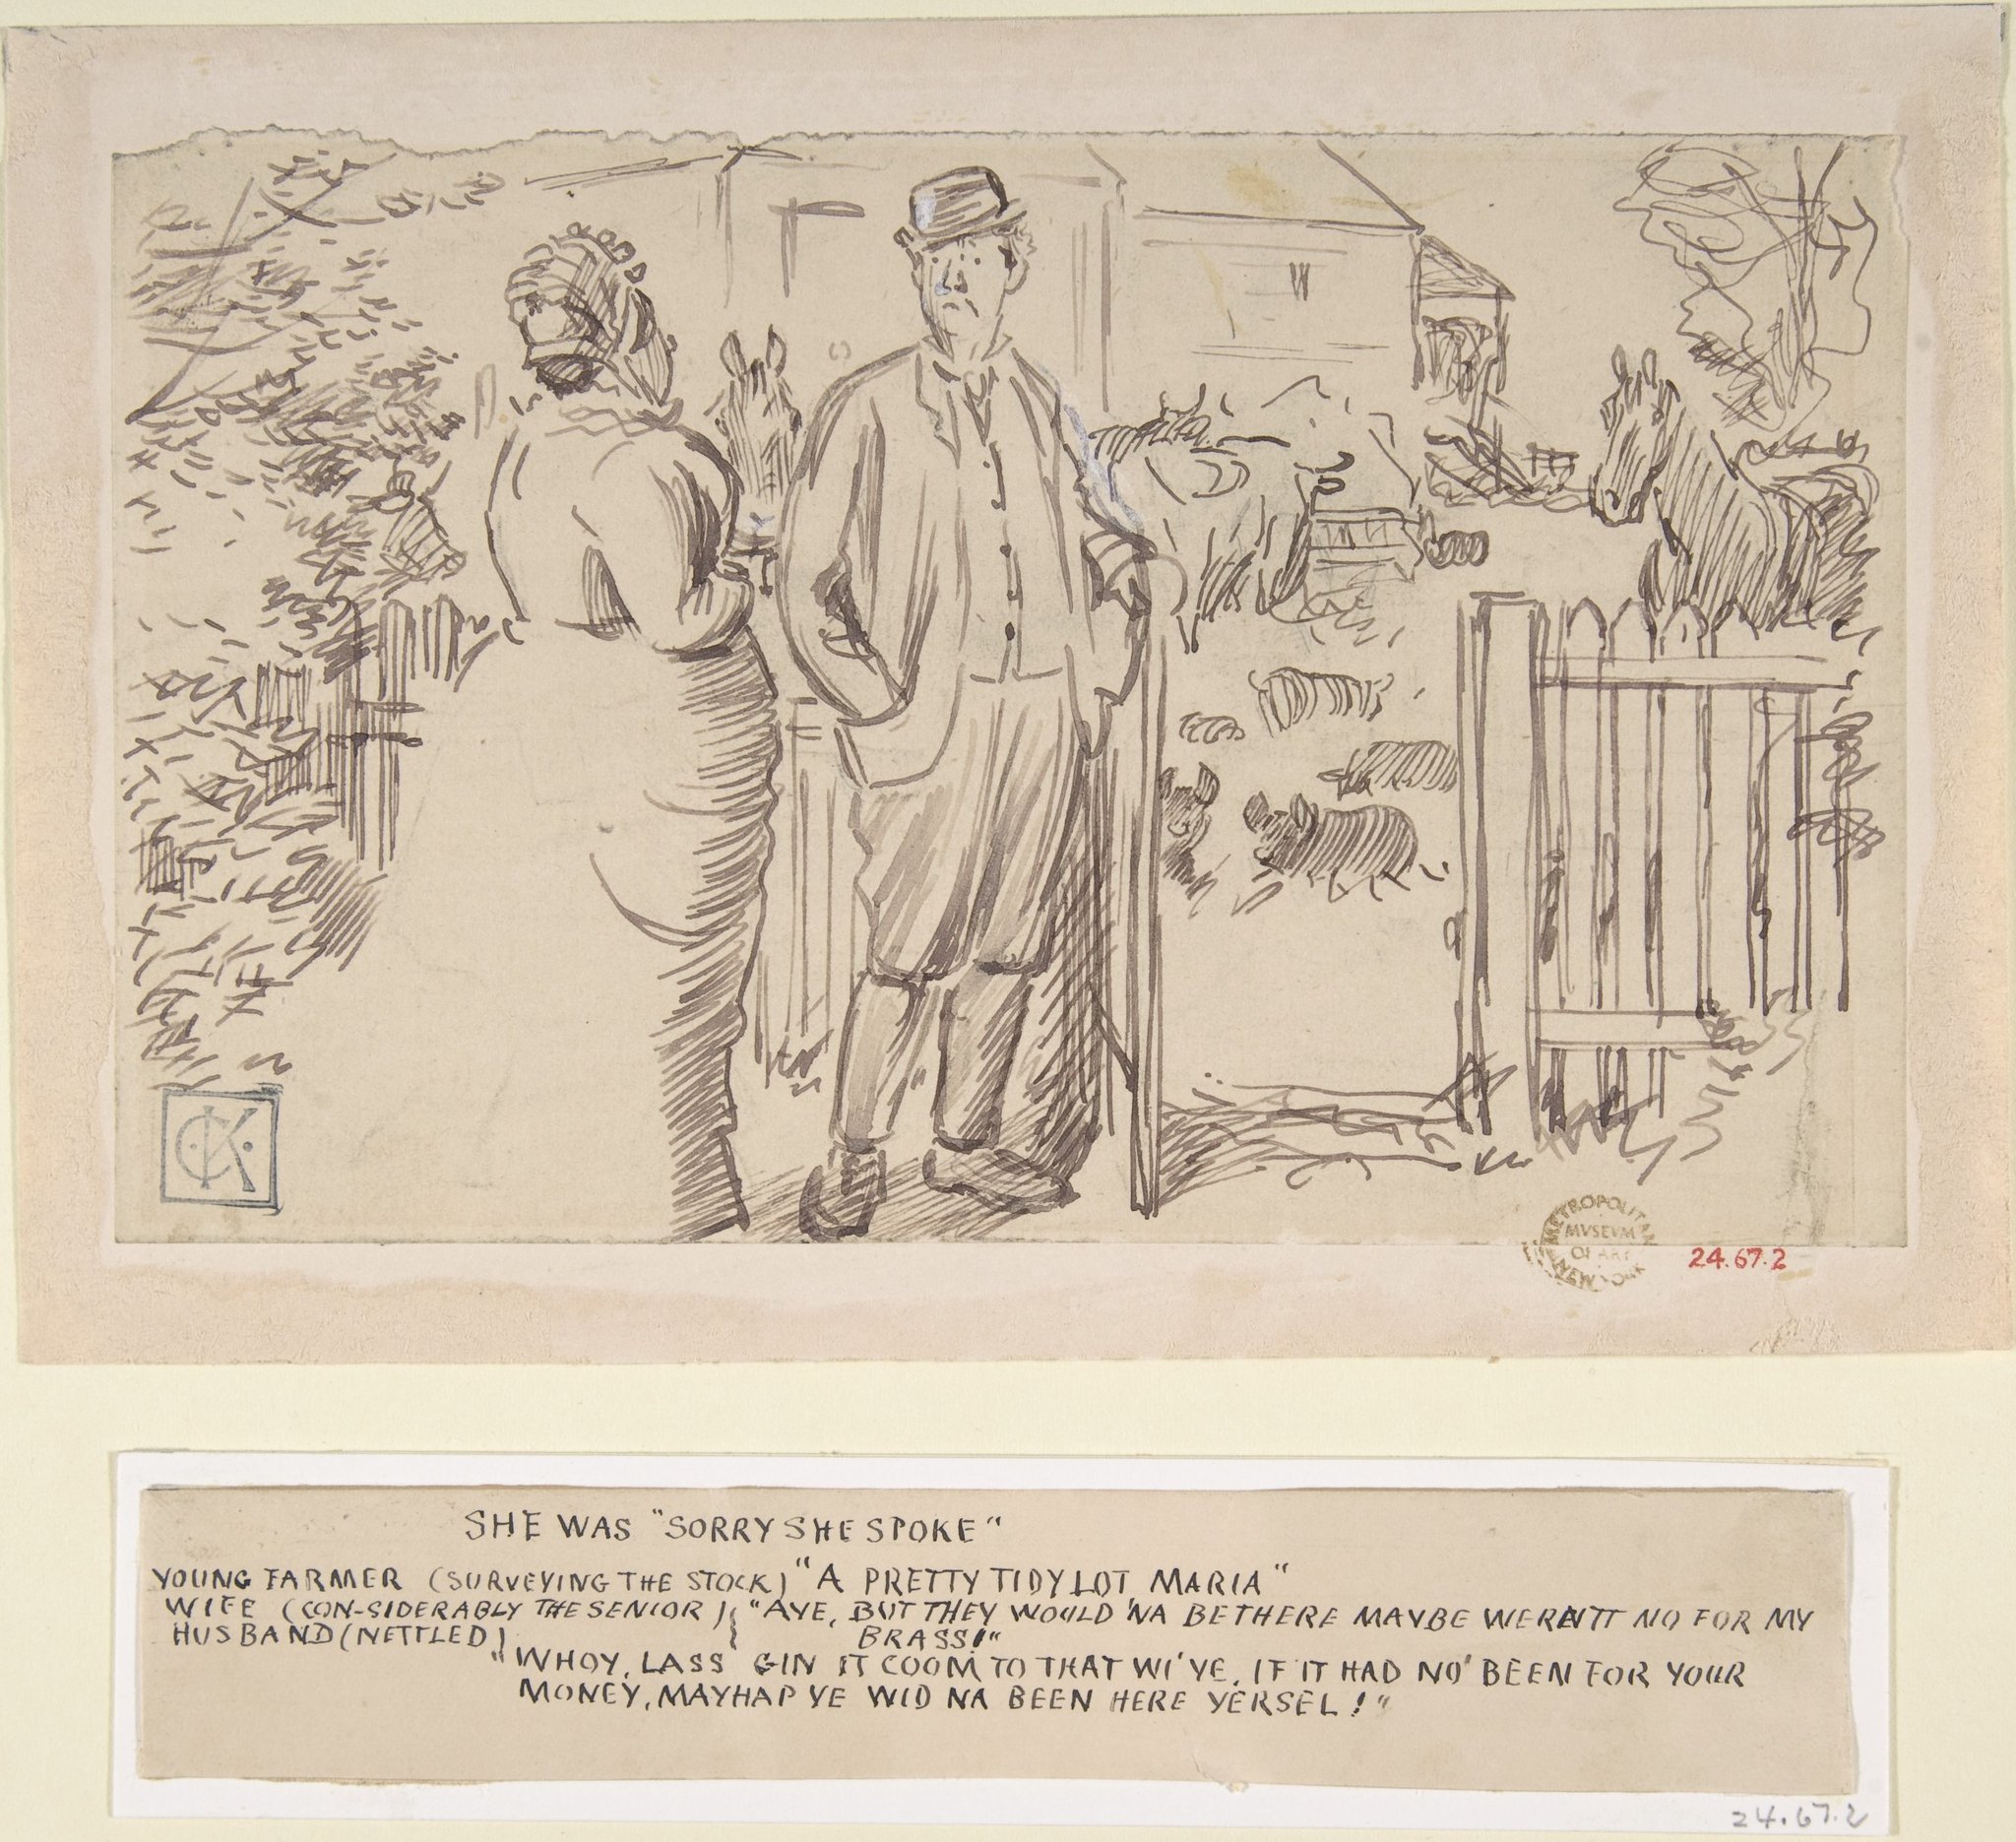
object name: drawing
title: She was "Sorry She Spoke"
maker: charles samuel keene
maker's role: artist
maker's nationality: british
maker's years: 1823-1891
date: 1870-1891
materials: gouache, ink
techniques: brush, pen, wash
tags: animals,men,women